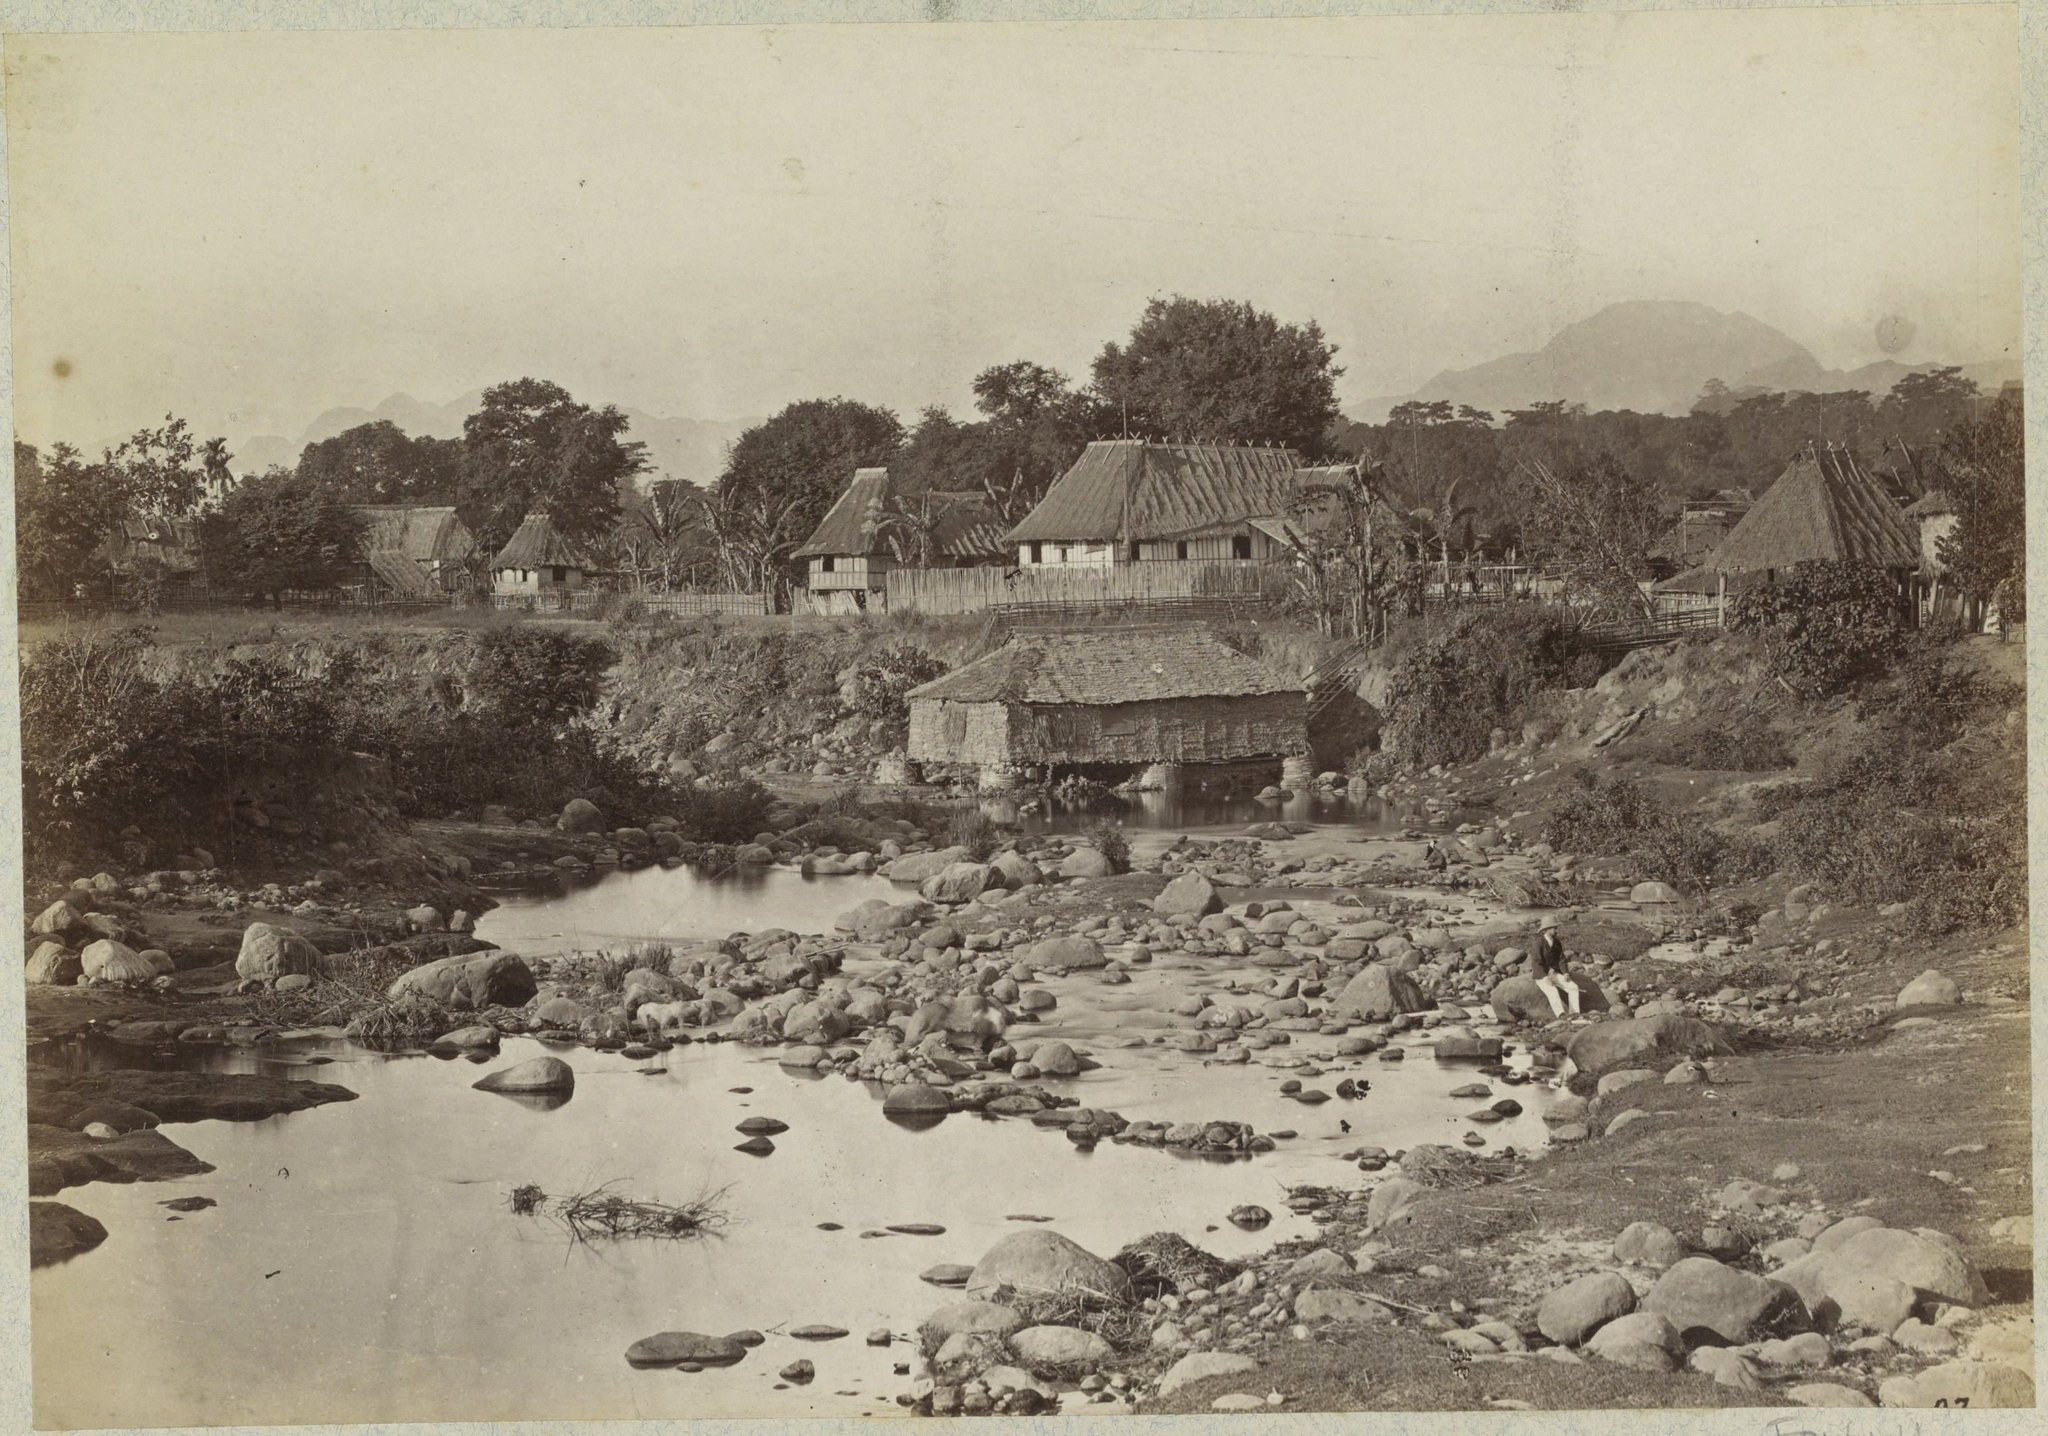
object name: photograph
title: Huizen bij een rotsachtige rivierbedding met rechts een Europeaan, vermoedelijk op de Filipijnen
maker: Anonymous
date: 1870-1891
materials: paper, photographic support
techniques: albumen print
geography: philippines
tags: prospect of village, silhouette of village, philippines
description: Onderdeel van Fotoalbum van een reis naar Manilla.